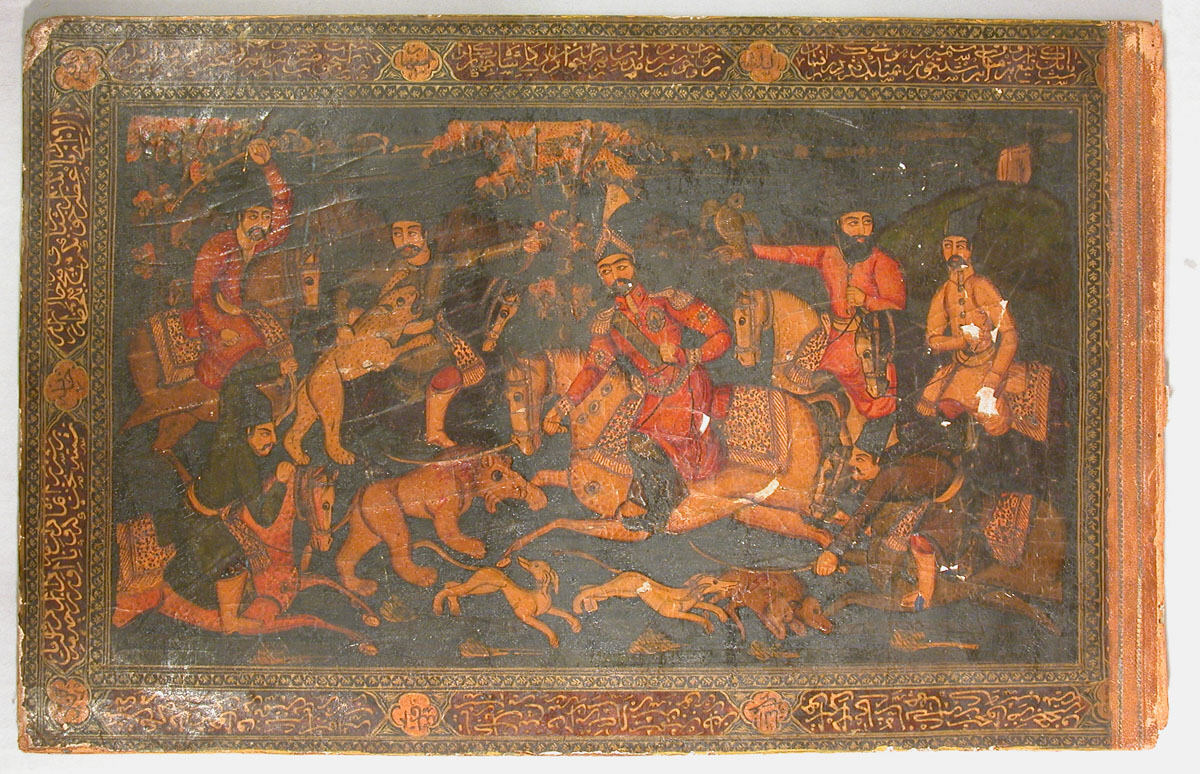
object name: bookbinding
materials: leather, board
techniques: lacquer, painting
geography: iran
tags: animals,men,hunting,dogs,horses